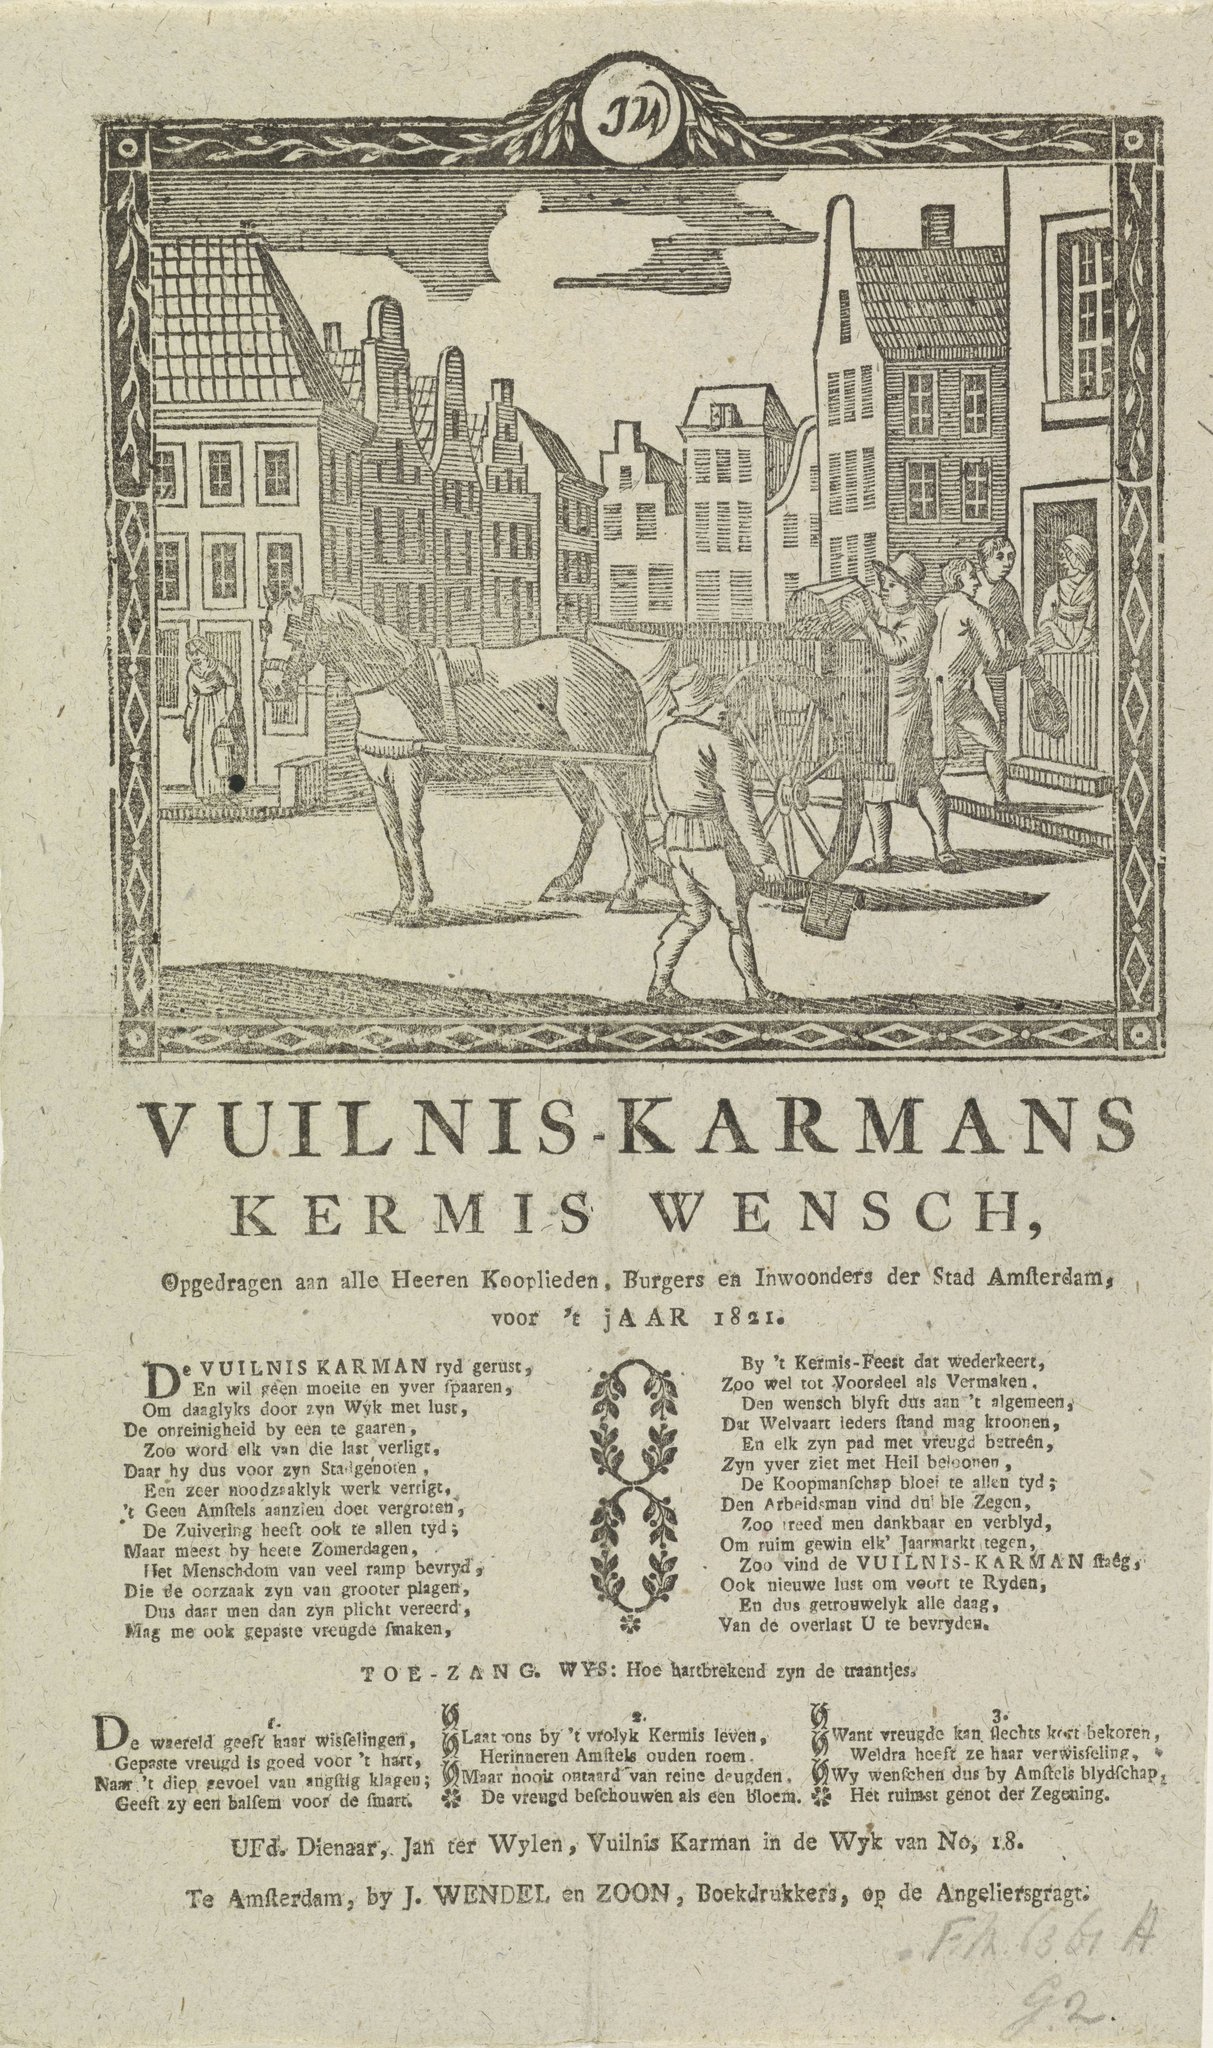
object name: fair print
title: Kermisprent van de vuilnismannen van Amsterdam voor het jaar 1821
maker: Anonymous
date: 1821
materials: paper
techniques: letterpress printing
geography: amsterdam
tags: street, garbage collection, amsterdam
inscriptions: collector's mark: Lugt 2228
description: Kermisprent van de Amsterdamse vuilnismannen voor het jaar 1821. Gezicht met in een straat te Amsterdam waar een man een vuilnisemmer leeggooit in de kar en een andere man met de ratel draait. Twee andere mannen halen bij een huis geld op. Met gedicht in twee kolommen en een lied in drie verzen. Van de vuilniskarman in de wijk no. 18: Jan ter Wylen.